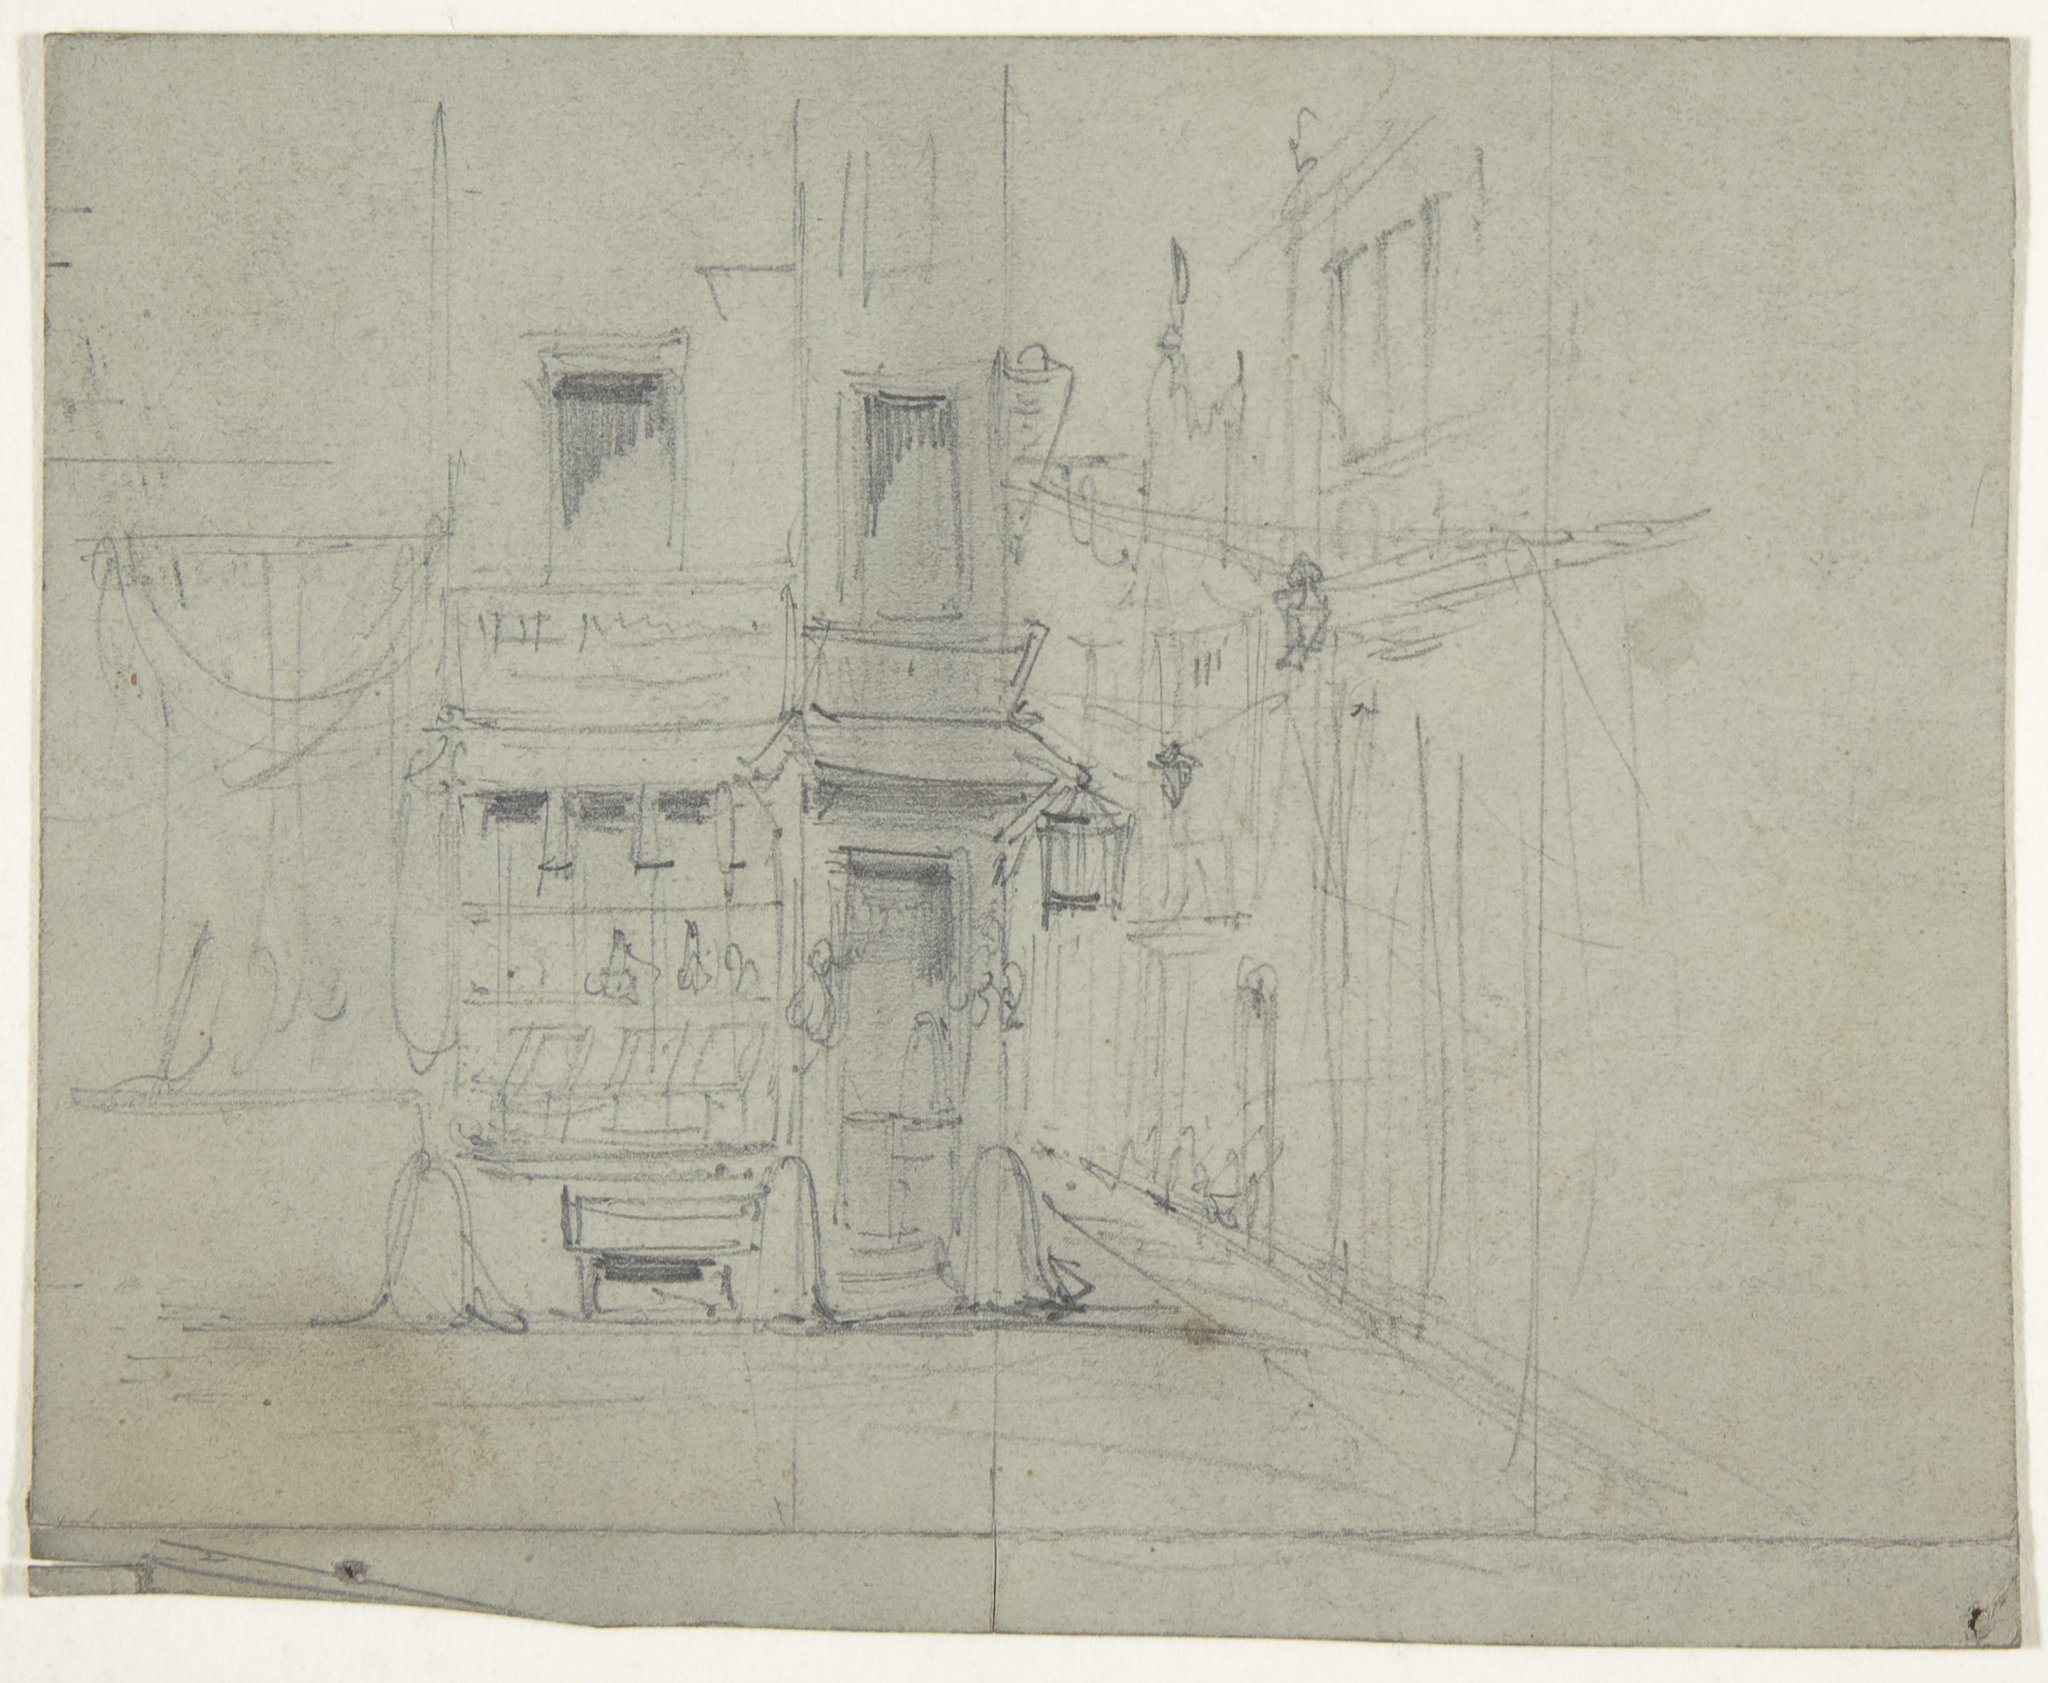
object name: drawing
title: Design for a Stage Set at the Opéra, Paris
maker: eugène cicéri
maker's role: artist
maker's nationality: french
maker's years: 1813-1890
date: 1830-1890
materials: graphite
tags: buildings,stage design